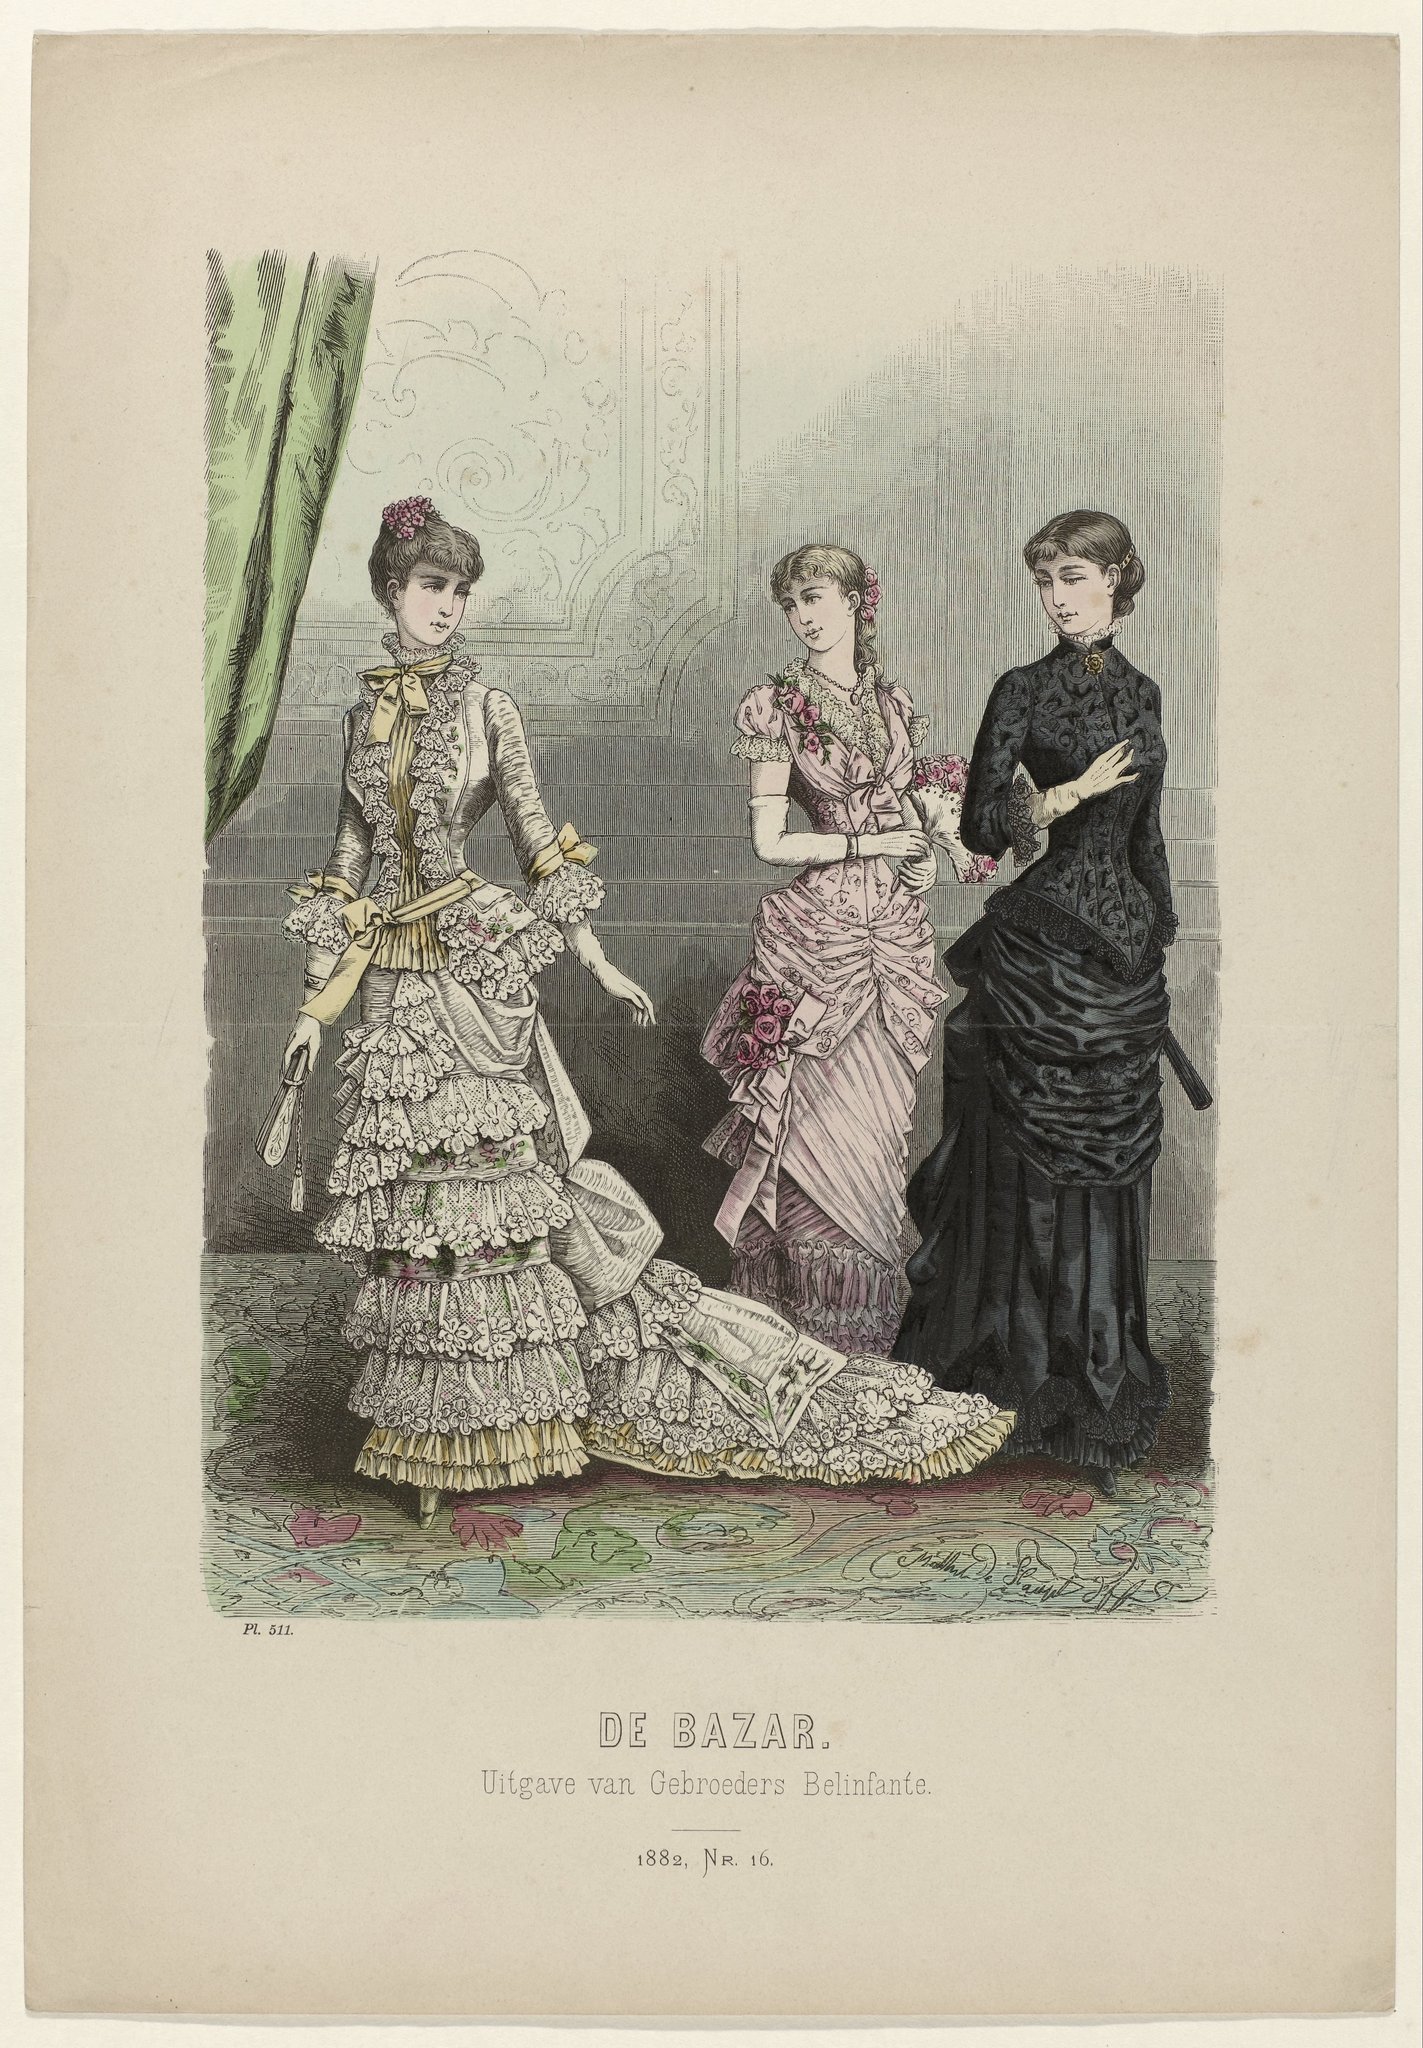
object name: fashion print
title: De Bazar, 1882, Nr. 16, Pl. 511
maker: Anonymous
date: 1882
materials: paper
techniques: hand coloring, engraving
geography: the hague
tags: cut flowers; nosegay, bunch of flowers, dress, gown: evening dress (+ women's clothes), gloves, mittens (long gloves) (+ women's clothes), fashion plates, fan (+ women's clothes), necklace (+ women's clothes)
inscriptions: caption: ‘DE BAZAR. / Uitgave van Gebroeders Belinfante. / 1882, Nr. 16’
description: Prent uit het modetijdschrift De Bazar, geïllustreerd Tijdschrift voor Modes en Handwerken (1857-1900).